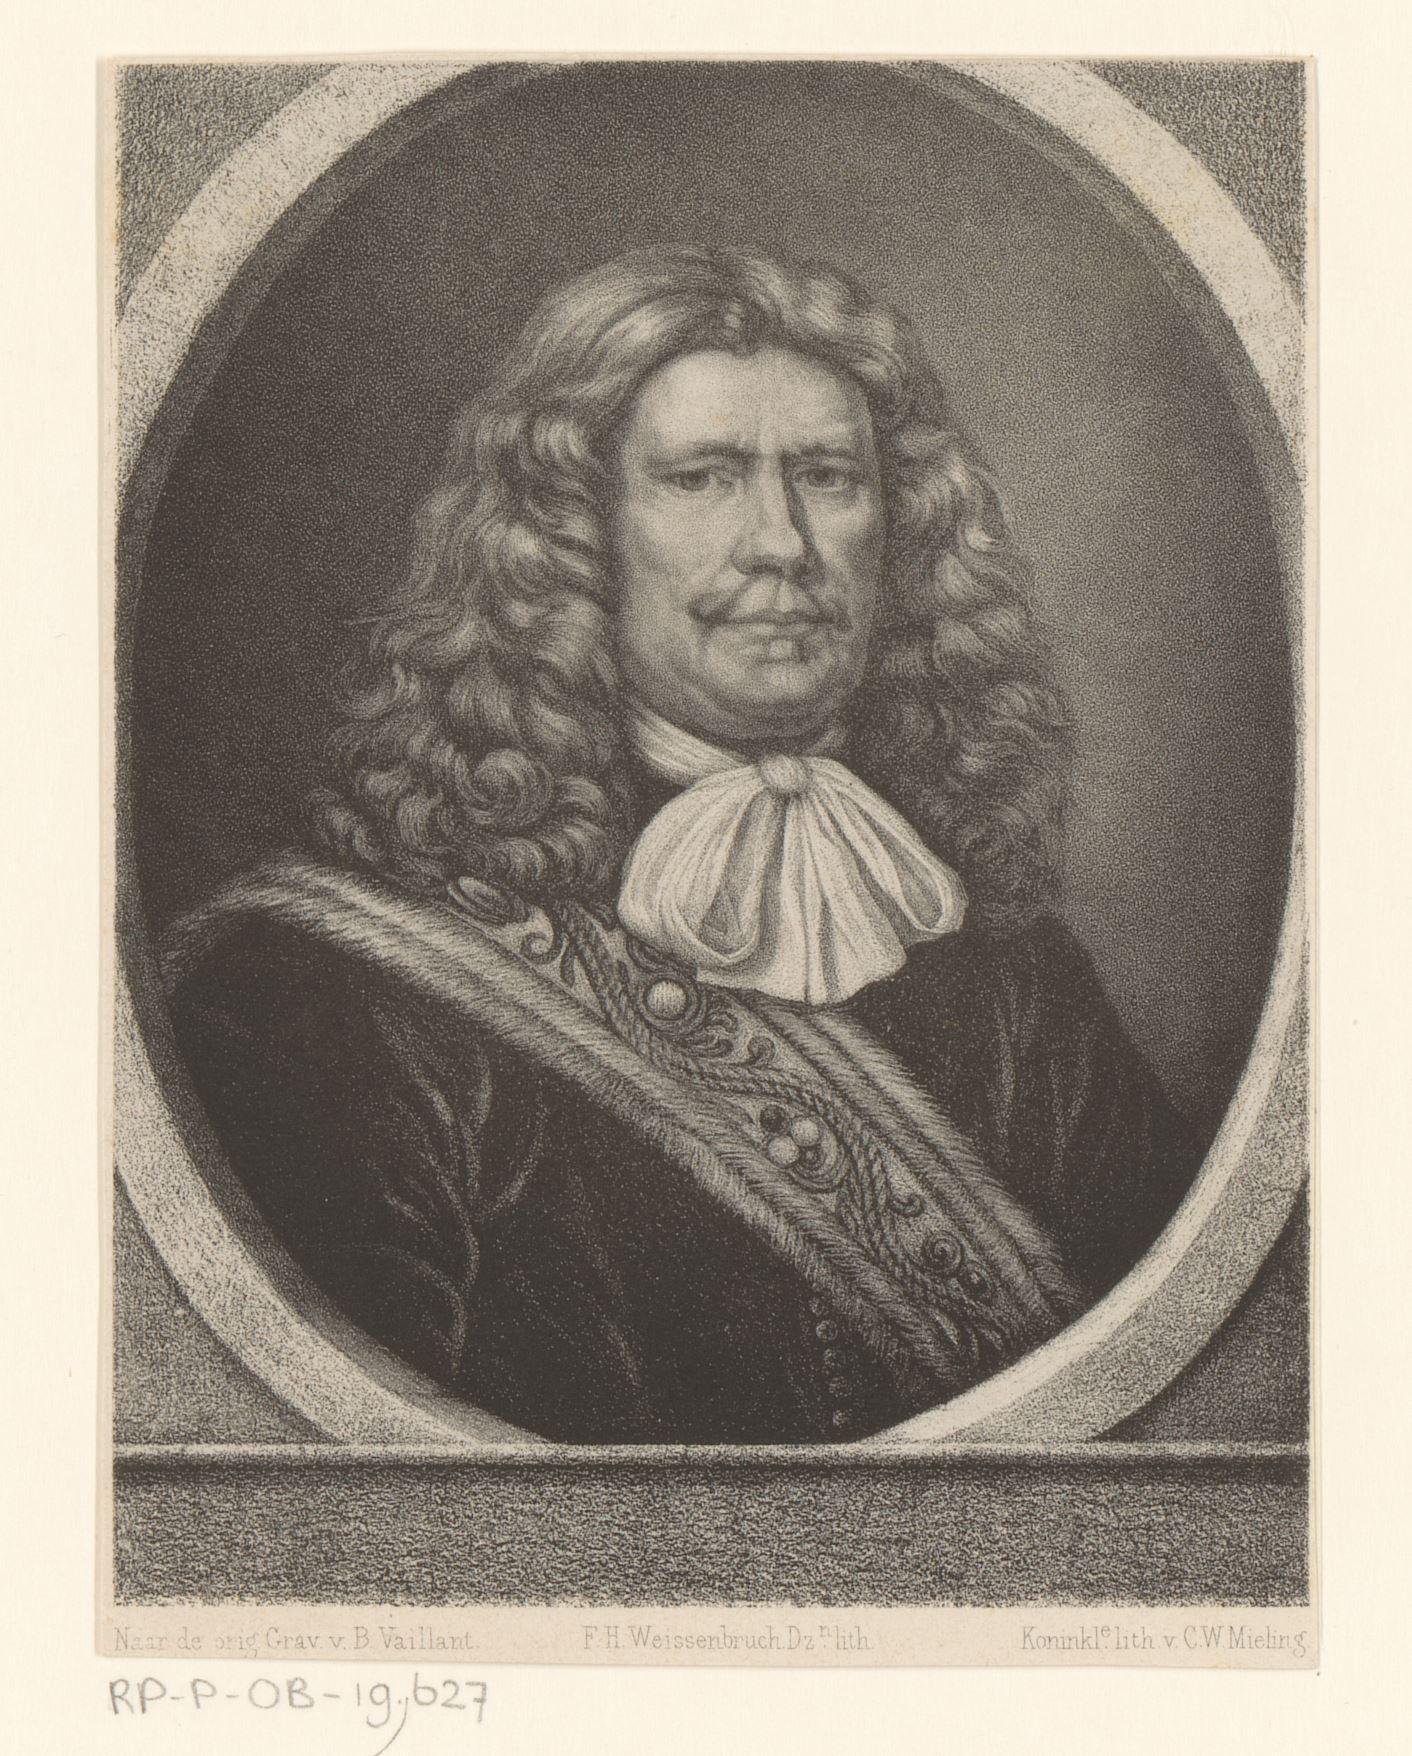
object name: book illustration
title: Portret van Isaac Sweers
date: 1858-1862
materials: paper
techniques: lithograph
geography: the hague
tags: nijmegen, historical persons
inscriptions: collector's mark: Lugt 2228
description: Prent uit: Jonge, J.C. de. Geschiedenis van het Nederlandsche zeewezen. Haarlem: Jonge, J.K.J. de, 1858-62.